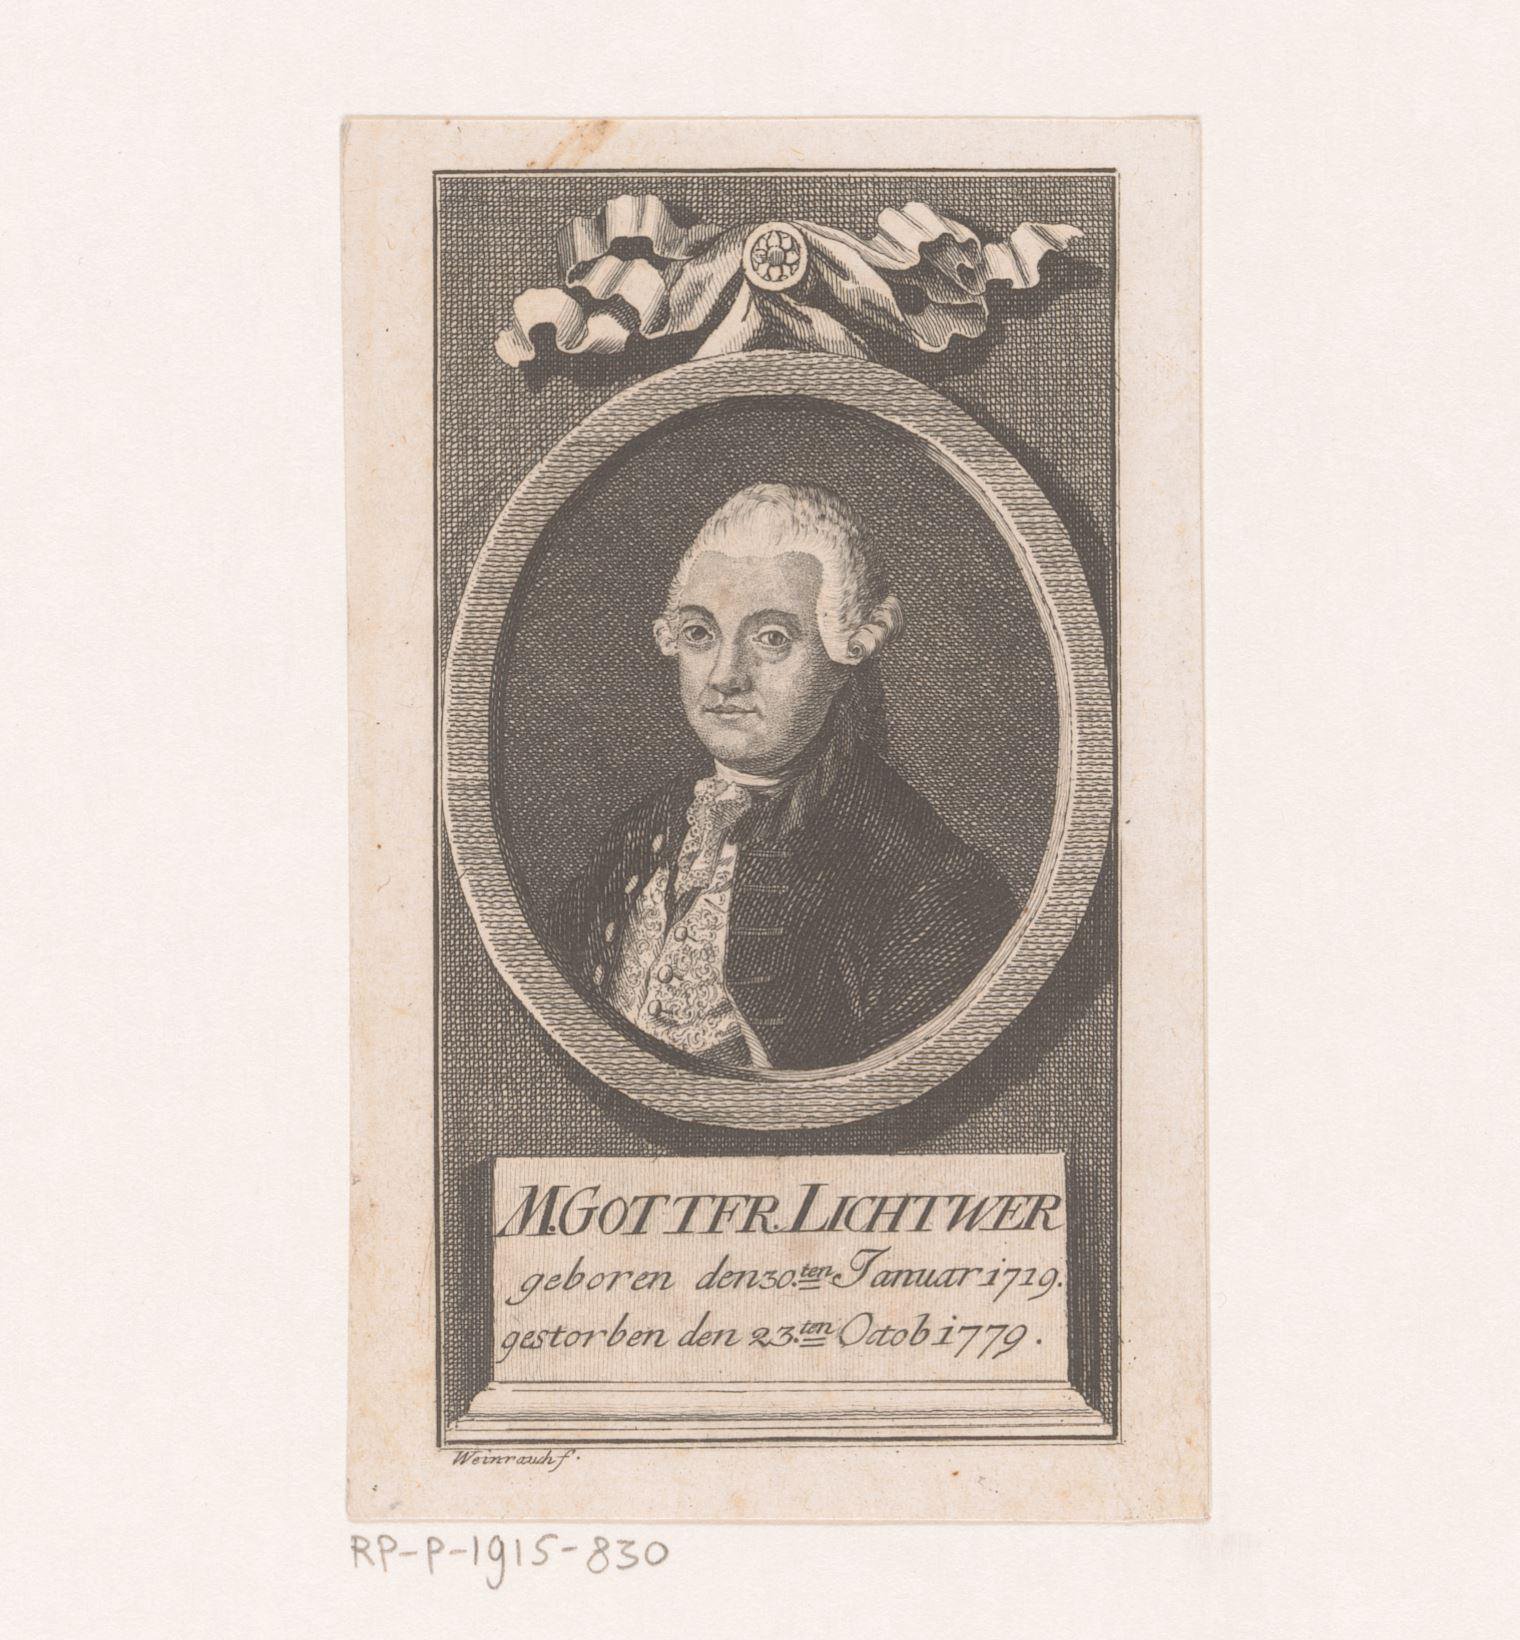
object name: print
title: Portret van Magnus Gottfried Lichtwer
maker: johann caspar weinrauch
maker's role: draughtsman, print maker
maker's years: 1765-1846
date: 1775-1846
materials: paper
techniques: engraving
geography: germany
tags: historical persons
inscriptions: collector's mark: Lugt 2228